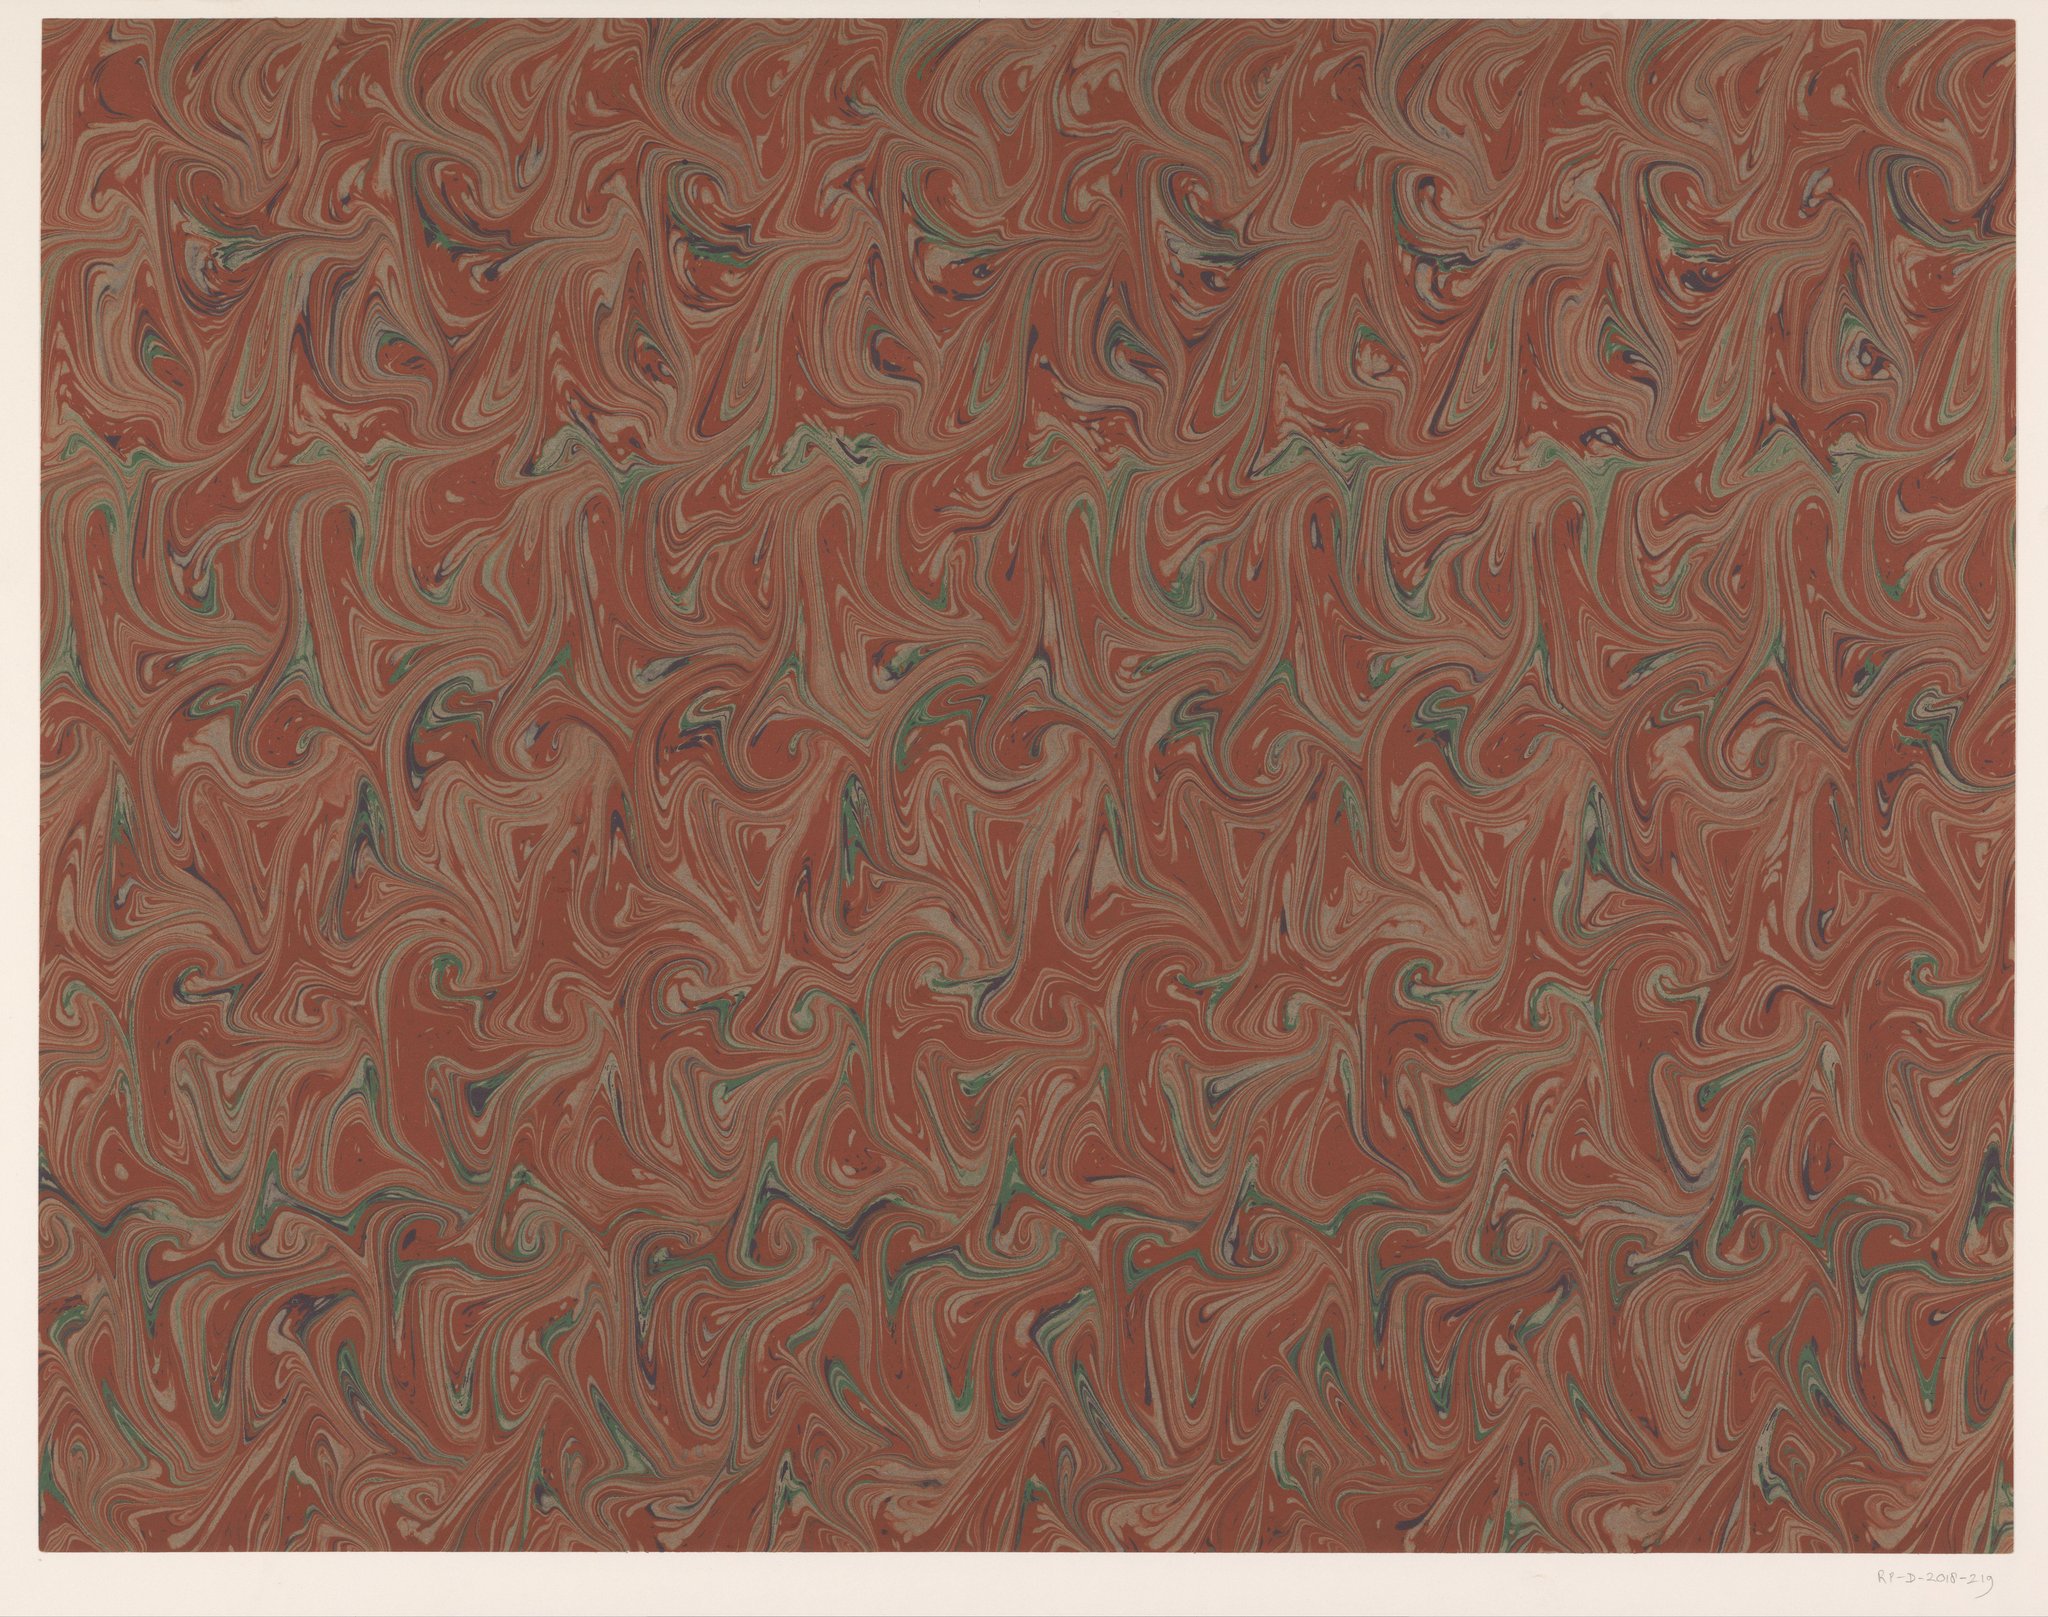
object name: marbled paper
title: Fantasiemarmer in verschillende tinten roodbruin, groen en blauw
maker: Anonymous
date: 1900-2000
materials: paint, paper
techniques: marbled paper